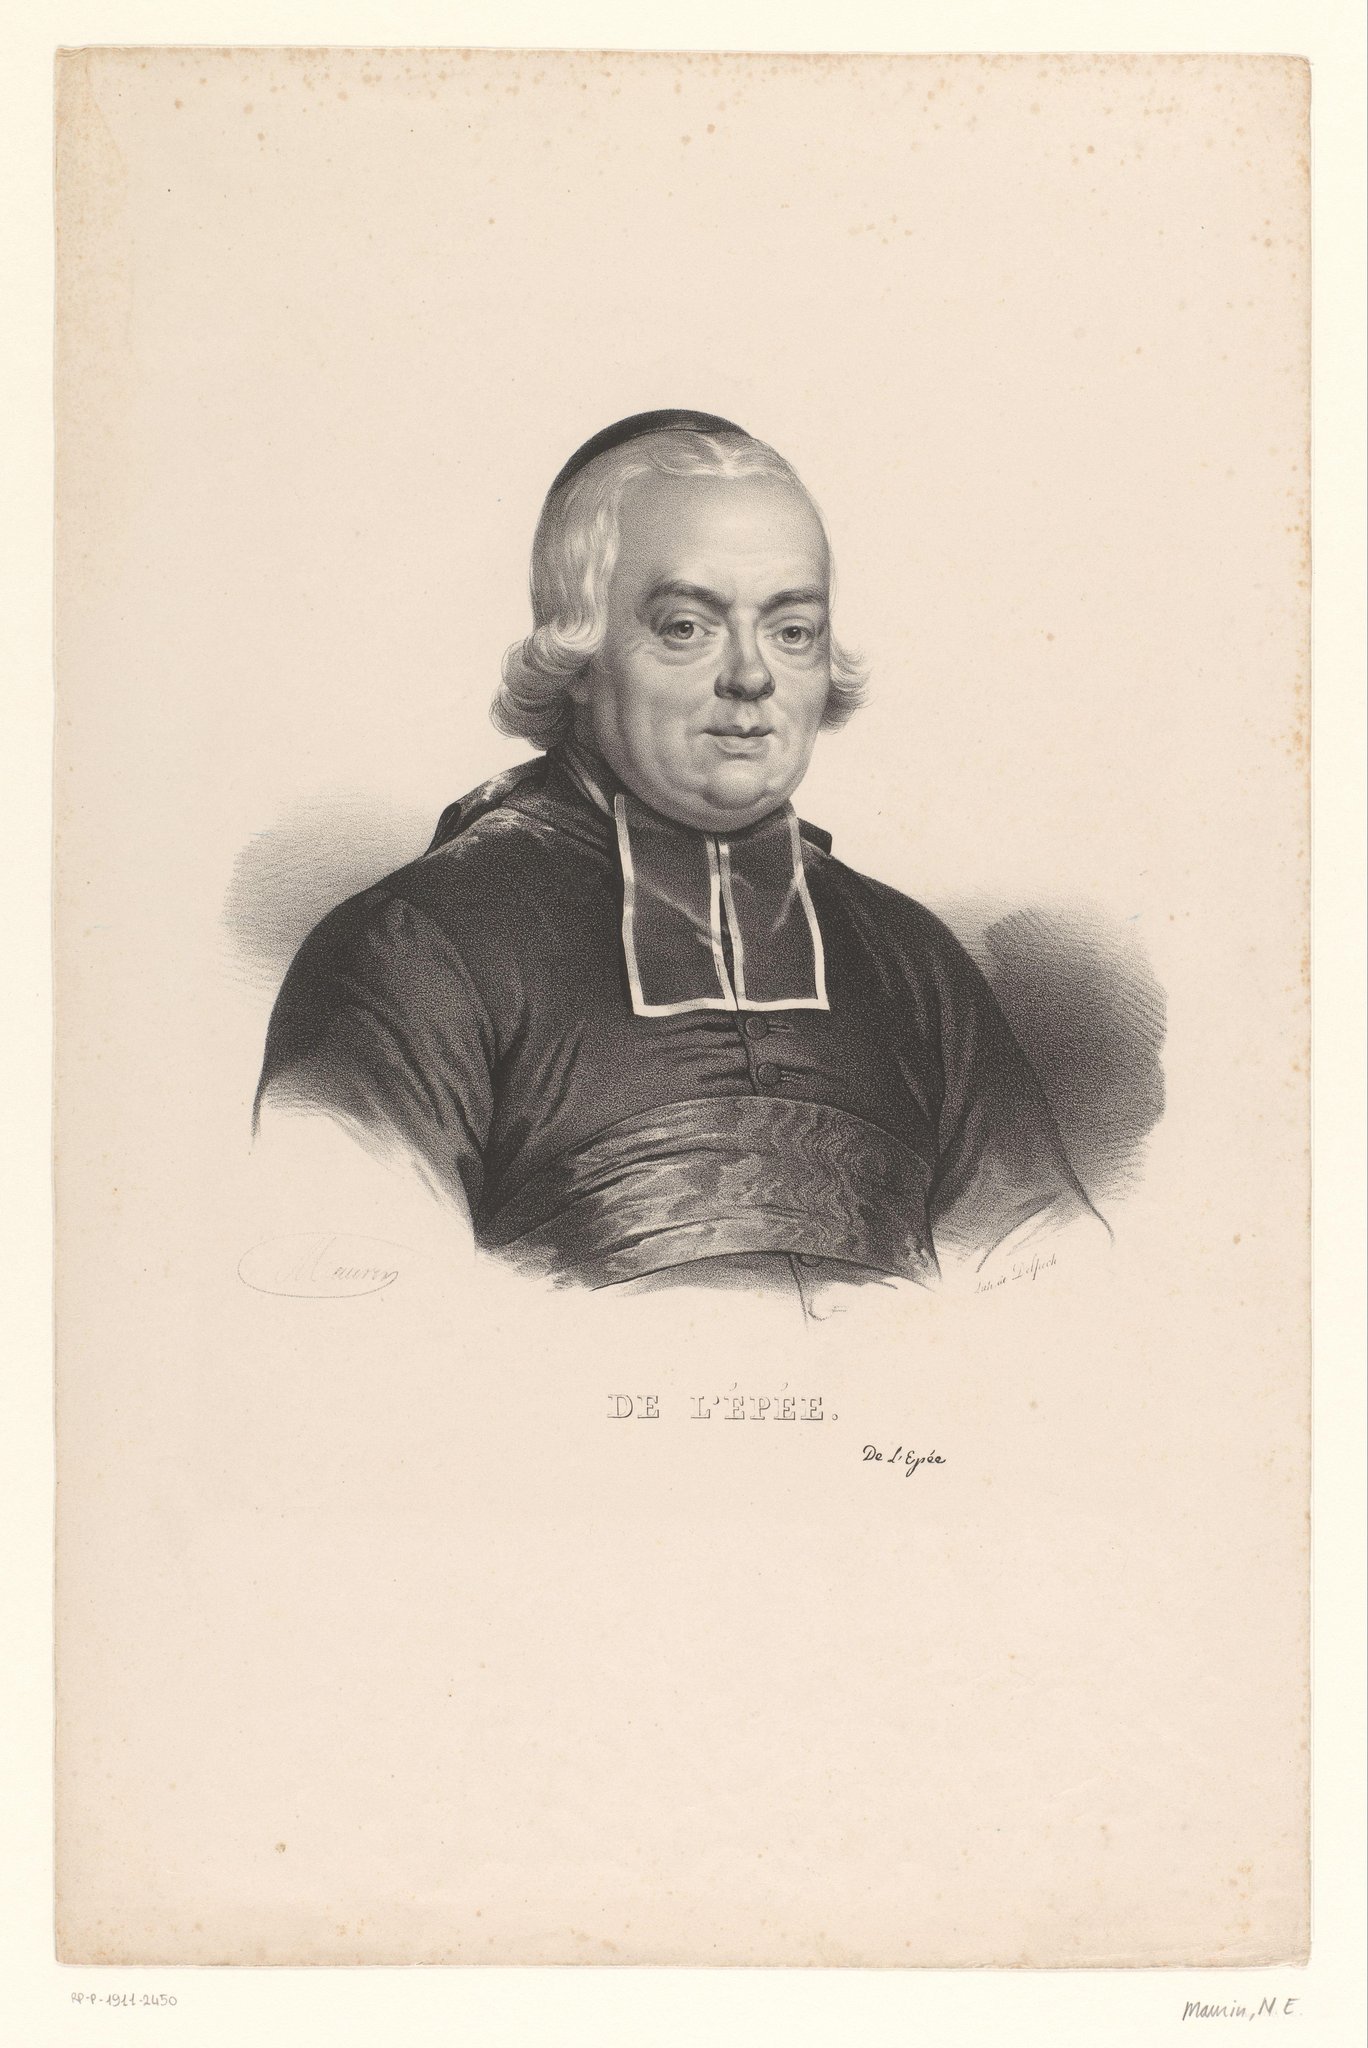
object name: print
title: De l'Épée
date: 1825-1842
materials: paper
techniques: lithograph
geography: paris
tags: paris, historical persons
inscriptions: collector's mark: Lugt 2228